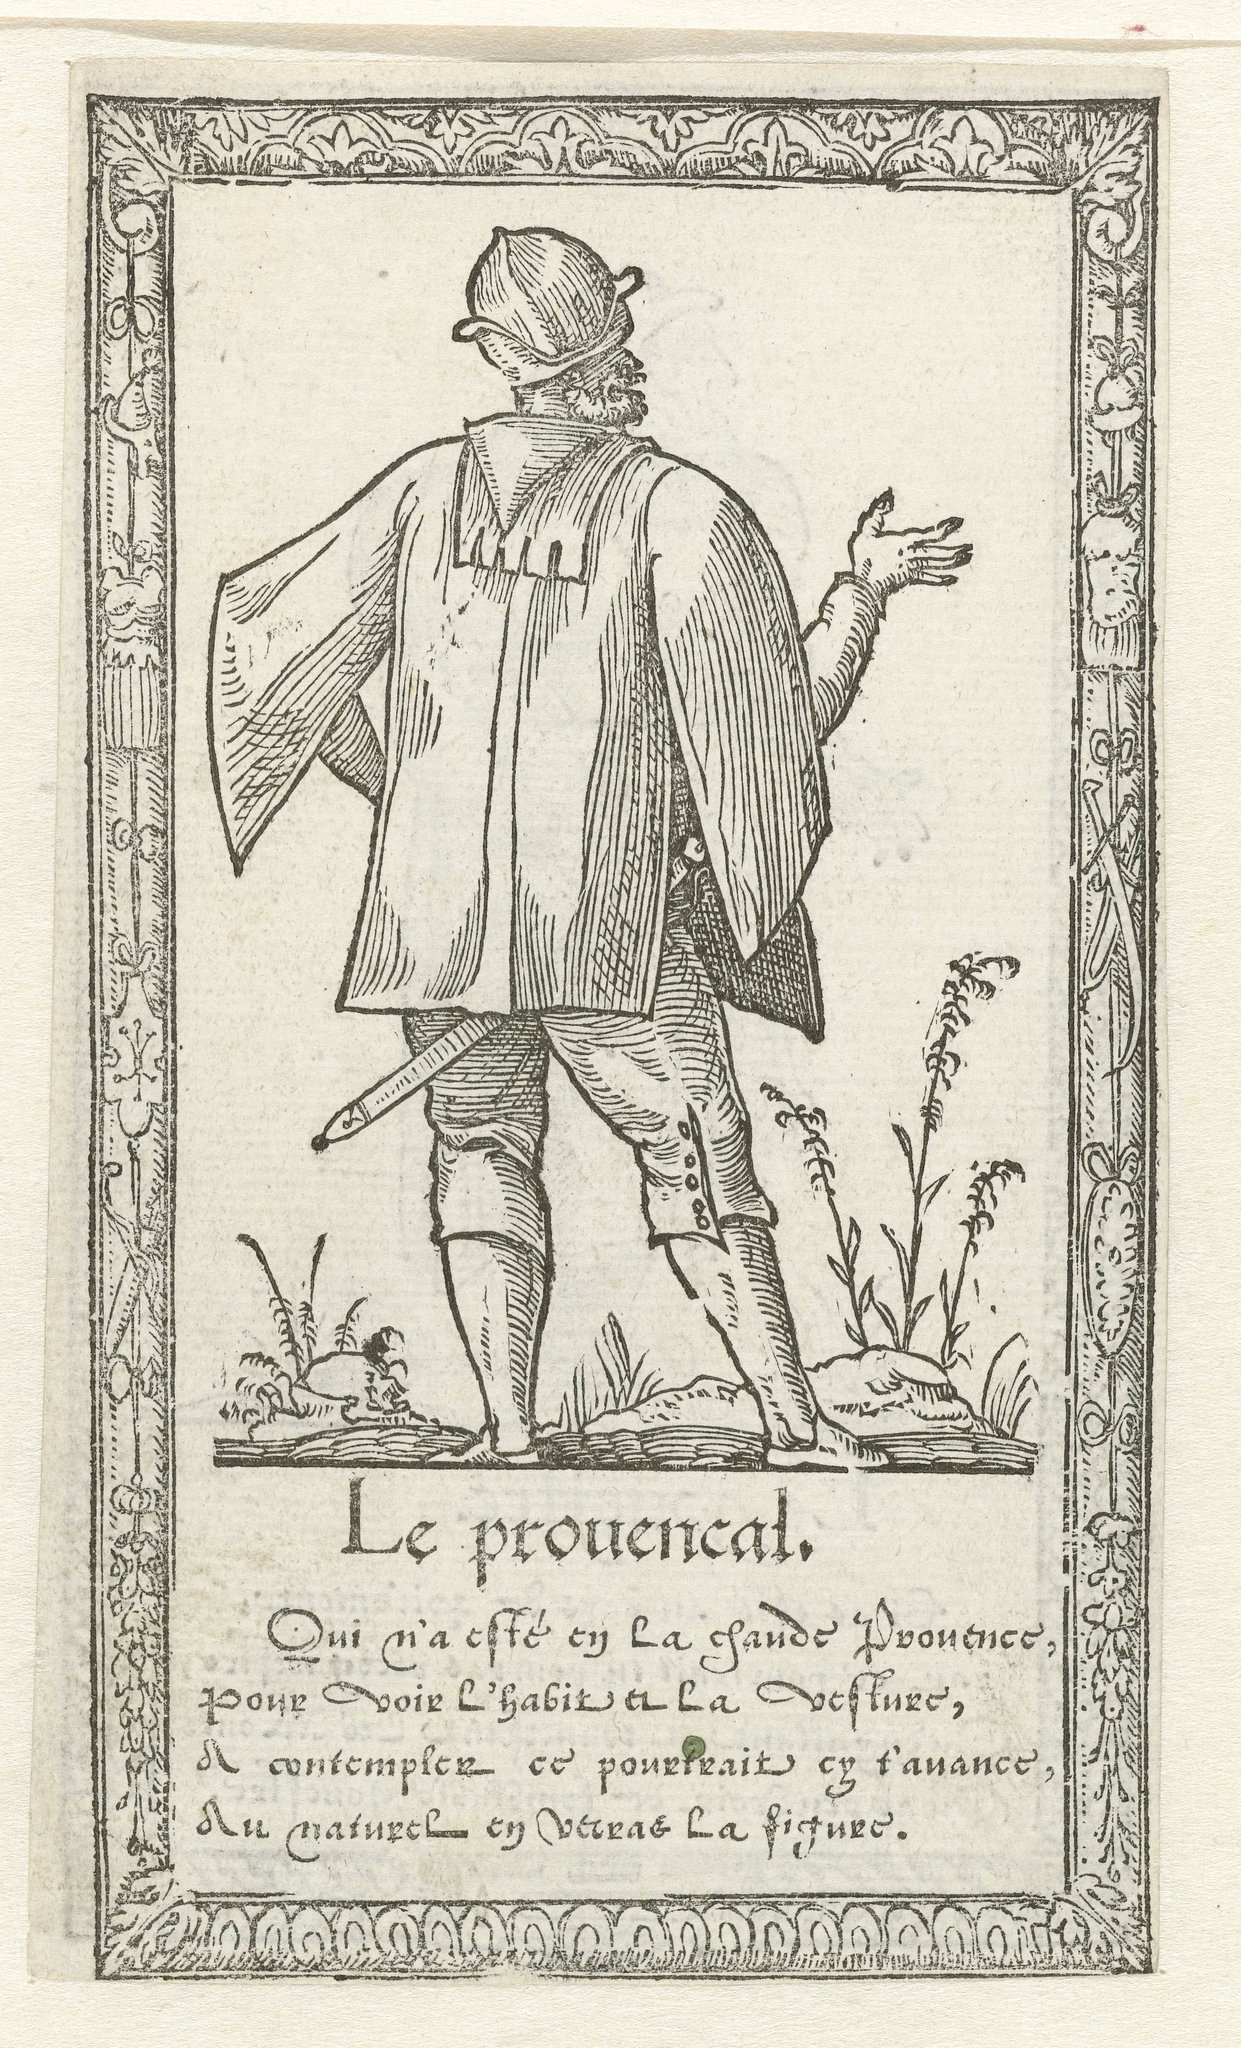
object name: print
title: Recueil de la diversité des habits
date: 1562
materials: paper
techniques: woodcut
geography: paris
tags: country dwellers, fashion plates, folk costume, regional costume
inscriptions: collector's mark: Lugt 2228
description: Dit is prent 32 uit een serie van 121. Binnen deze serie zijn er prenten gemaakt naar voorbeelden van Jean-François de Roberval en Enea Vico, onbekend welke precies.